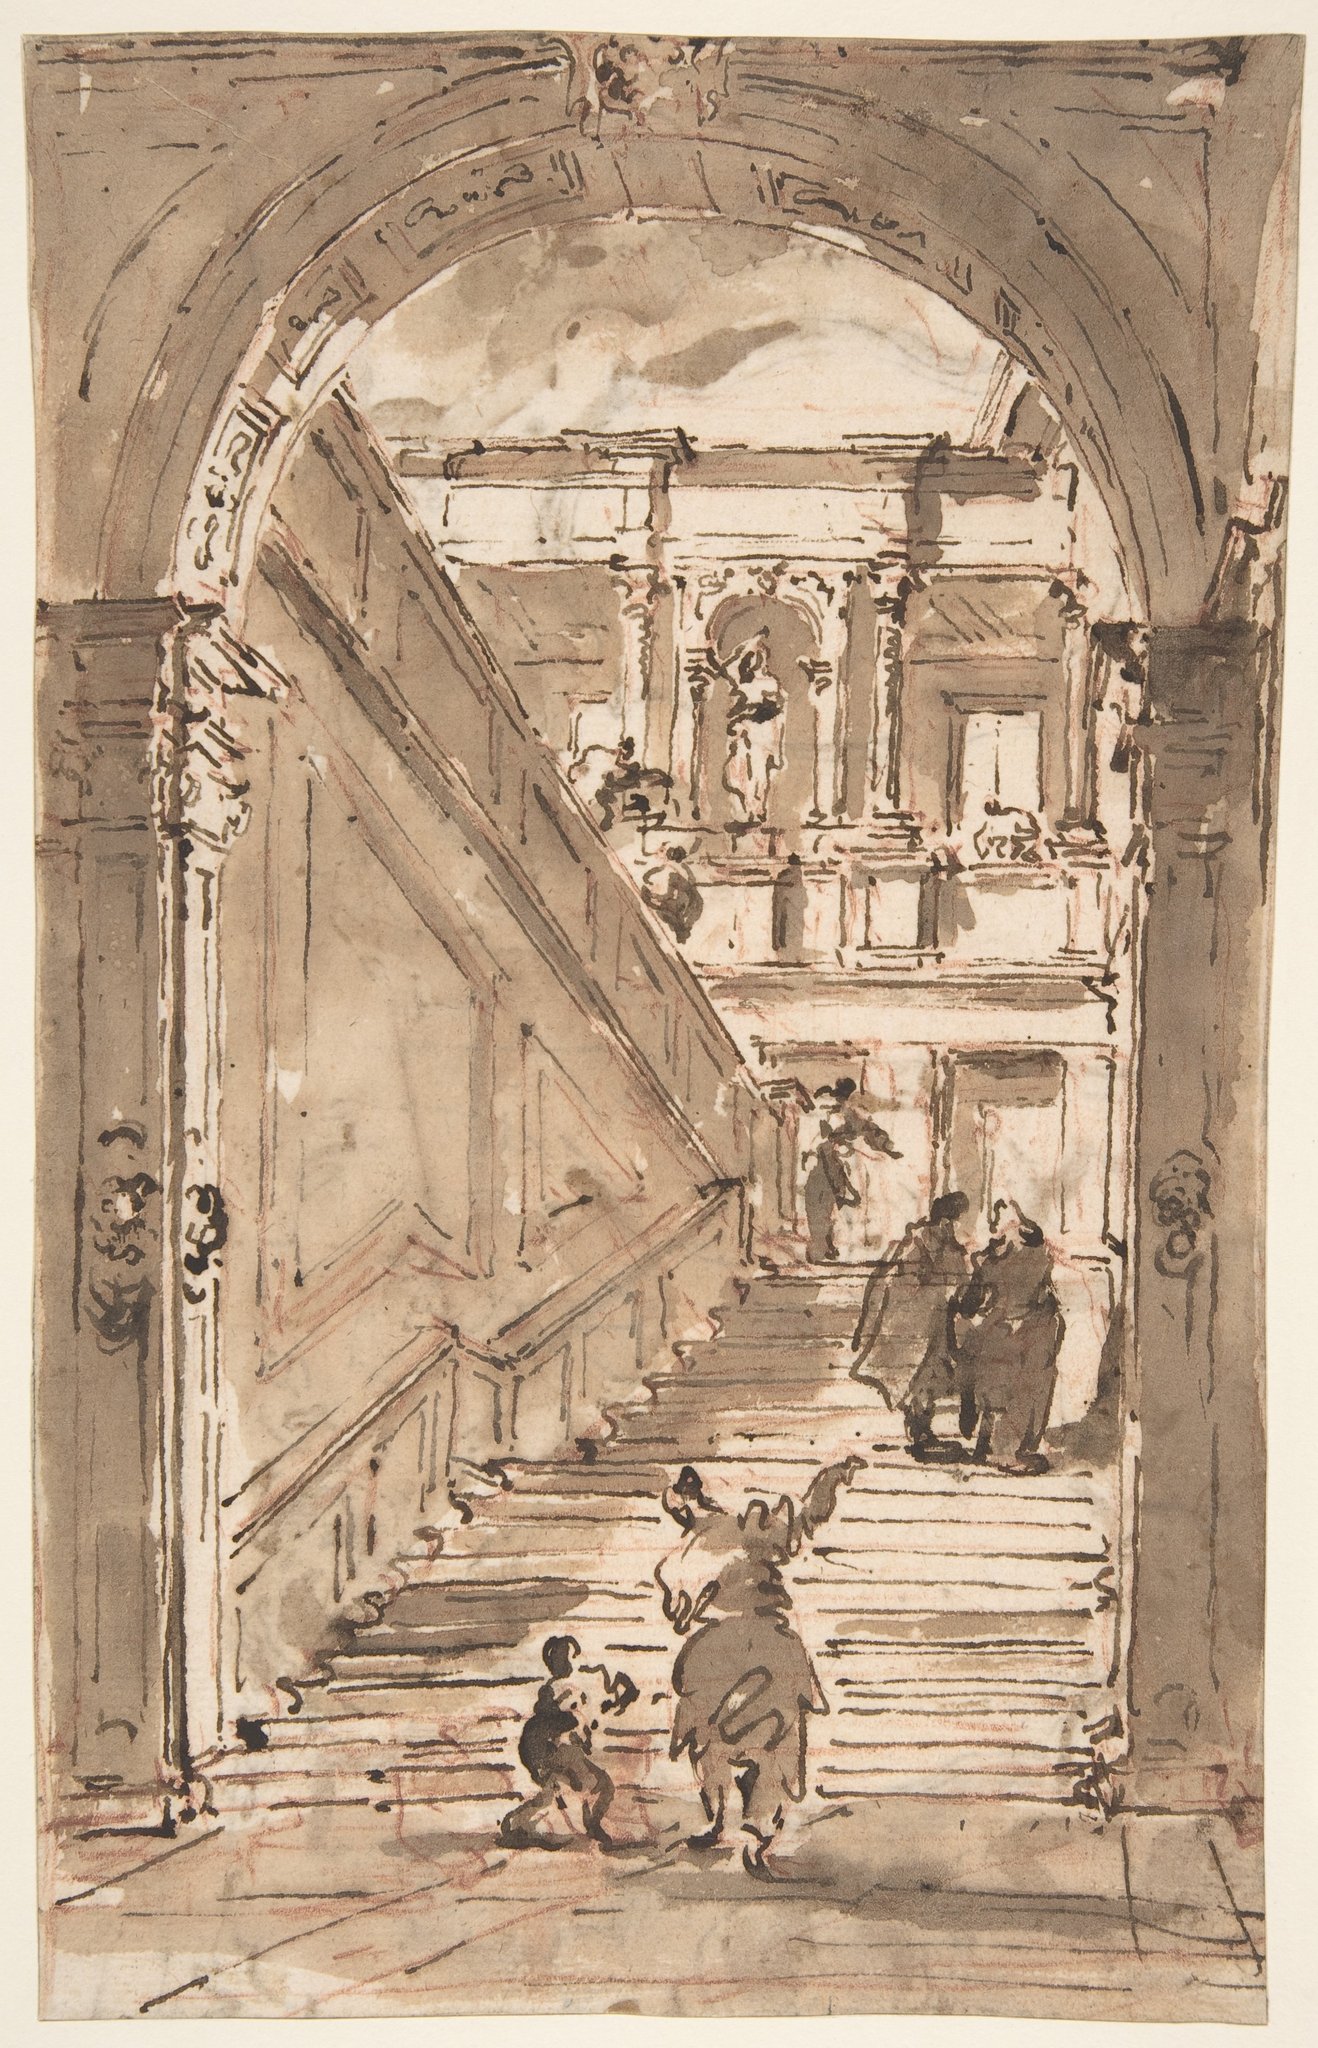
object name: drawing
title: Architectural Fantasy: Figures on a Grand Staircase (recto); Studies for the Frame of a Shaped Field (verso)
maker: francesco guardi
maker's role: artist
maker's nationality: italian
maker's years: 1712-1793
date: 1712-1793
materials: chalk, ink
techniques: brush, pen, wash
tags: human figures,stairs